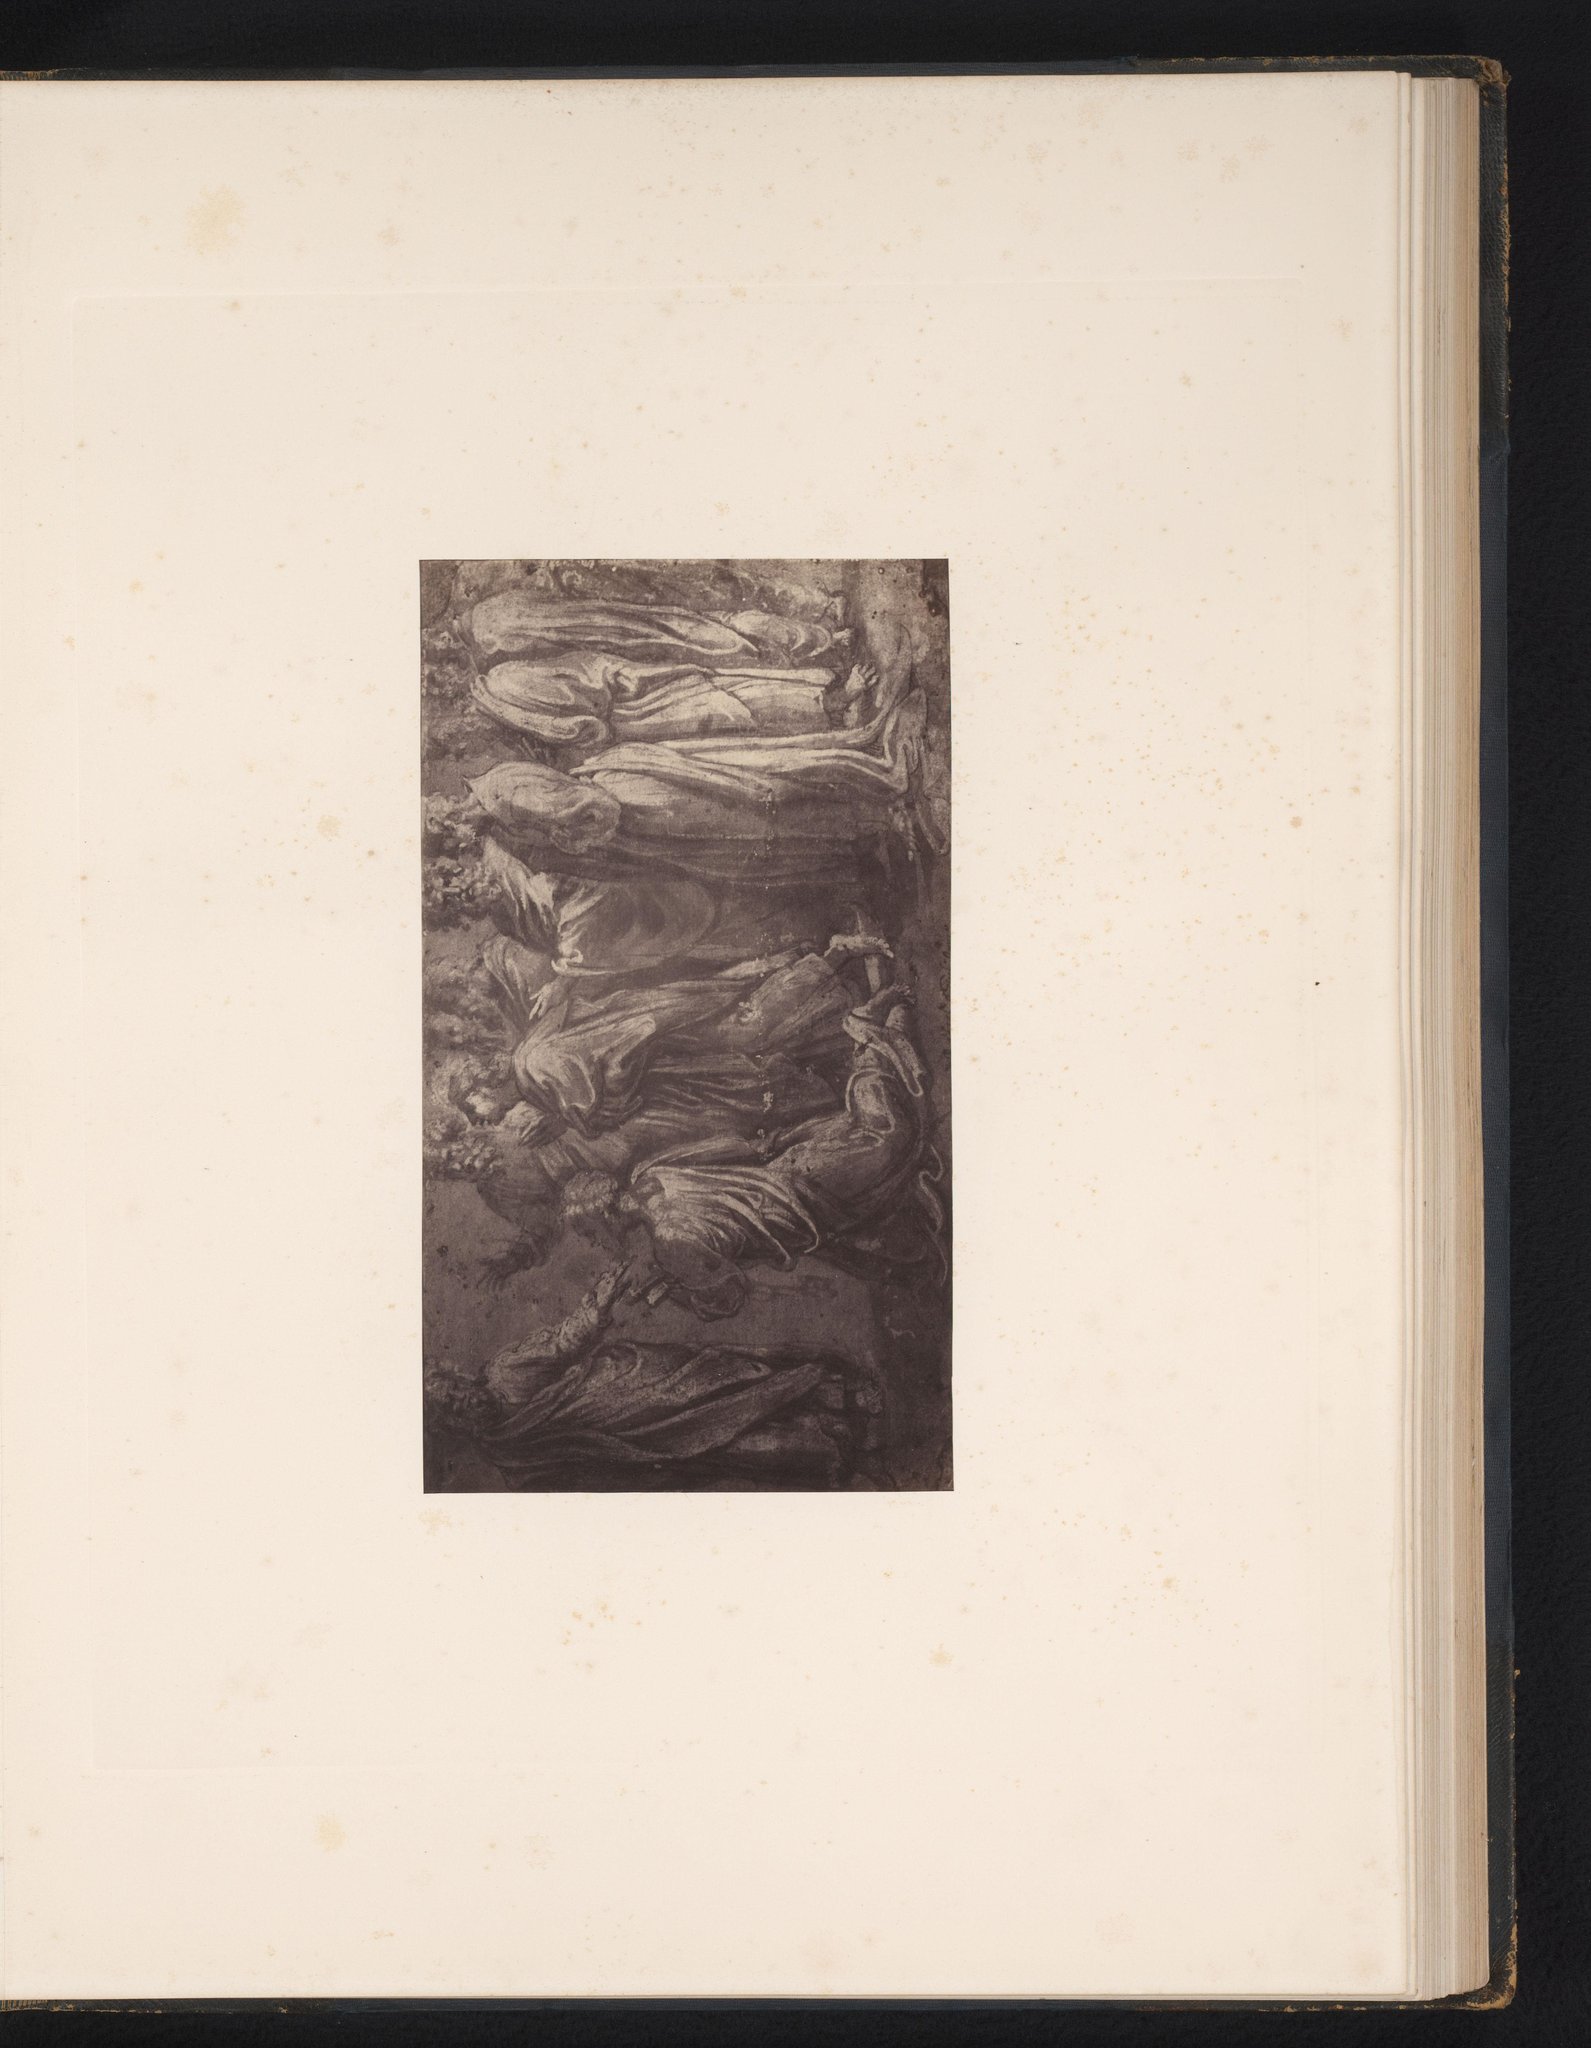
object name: page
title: Fotoreproductie van een tekening van Rafaël, Christus en zijn dicipelen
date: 1852-1857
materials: paper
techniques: albumen print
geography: windsor castle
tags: adult christ together with apostles, evangelists, saints, etc.